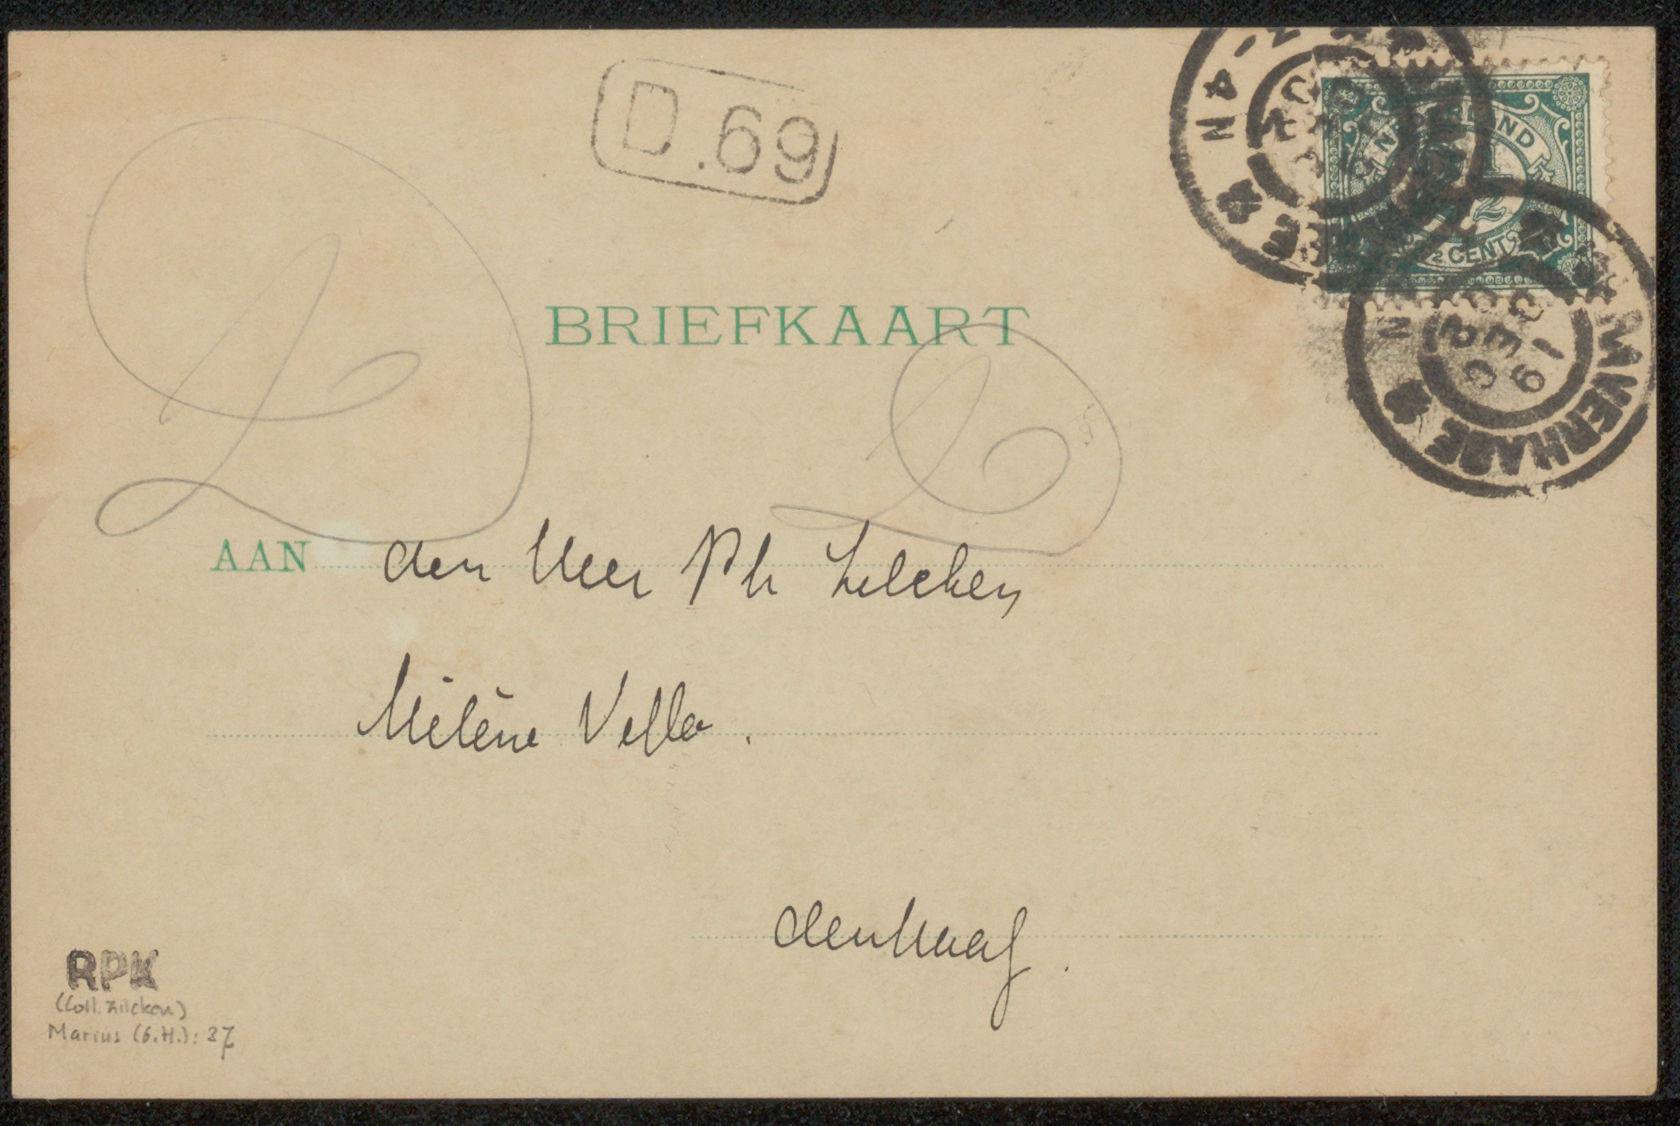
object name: postcard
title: Briefkaart aan Philip Zilcken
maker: grada hermina marius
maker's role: painter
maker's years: 1854-1919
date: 1902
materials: cardboard, ink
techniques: pen, writing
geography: the hague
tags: painter, draughtsman, philip zilcken, printed matter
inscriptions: collector's mark: ‘RPK’